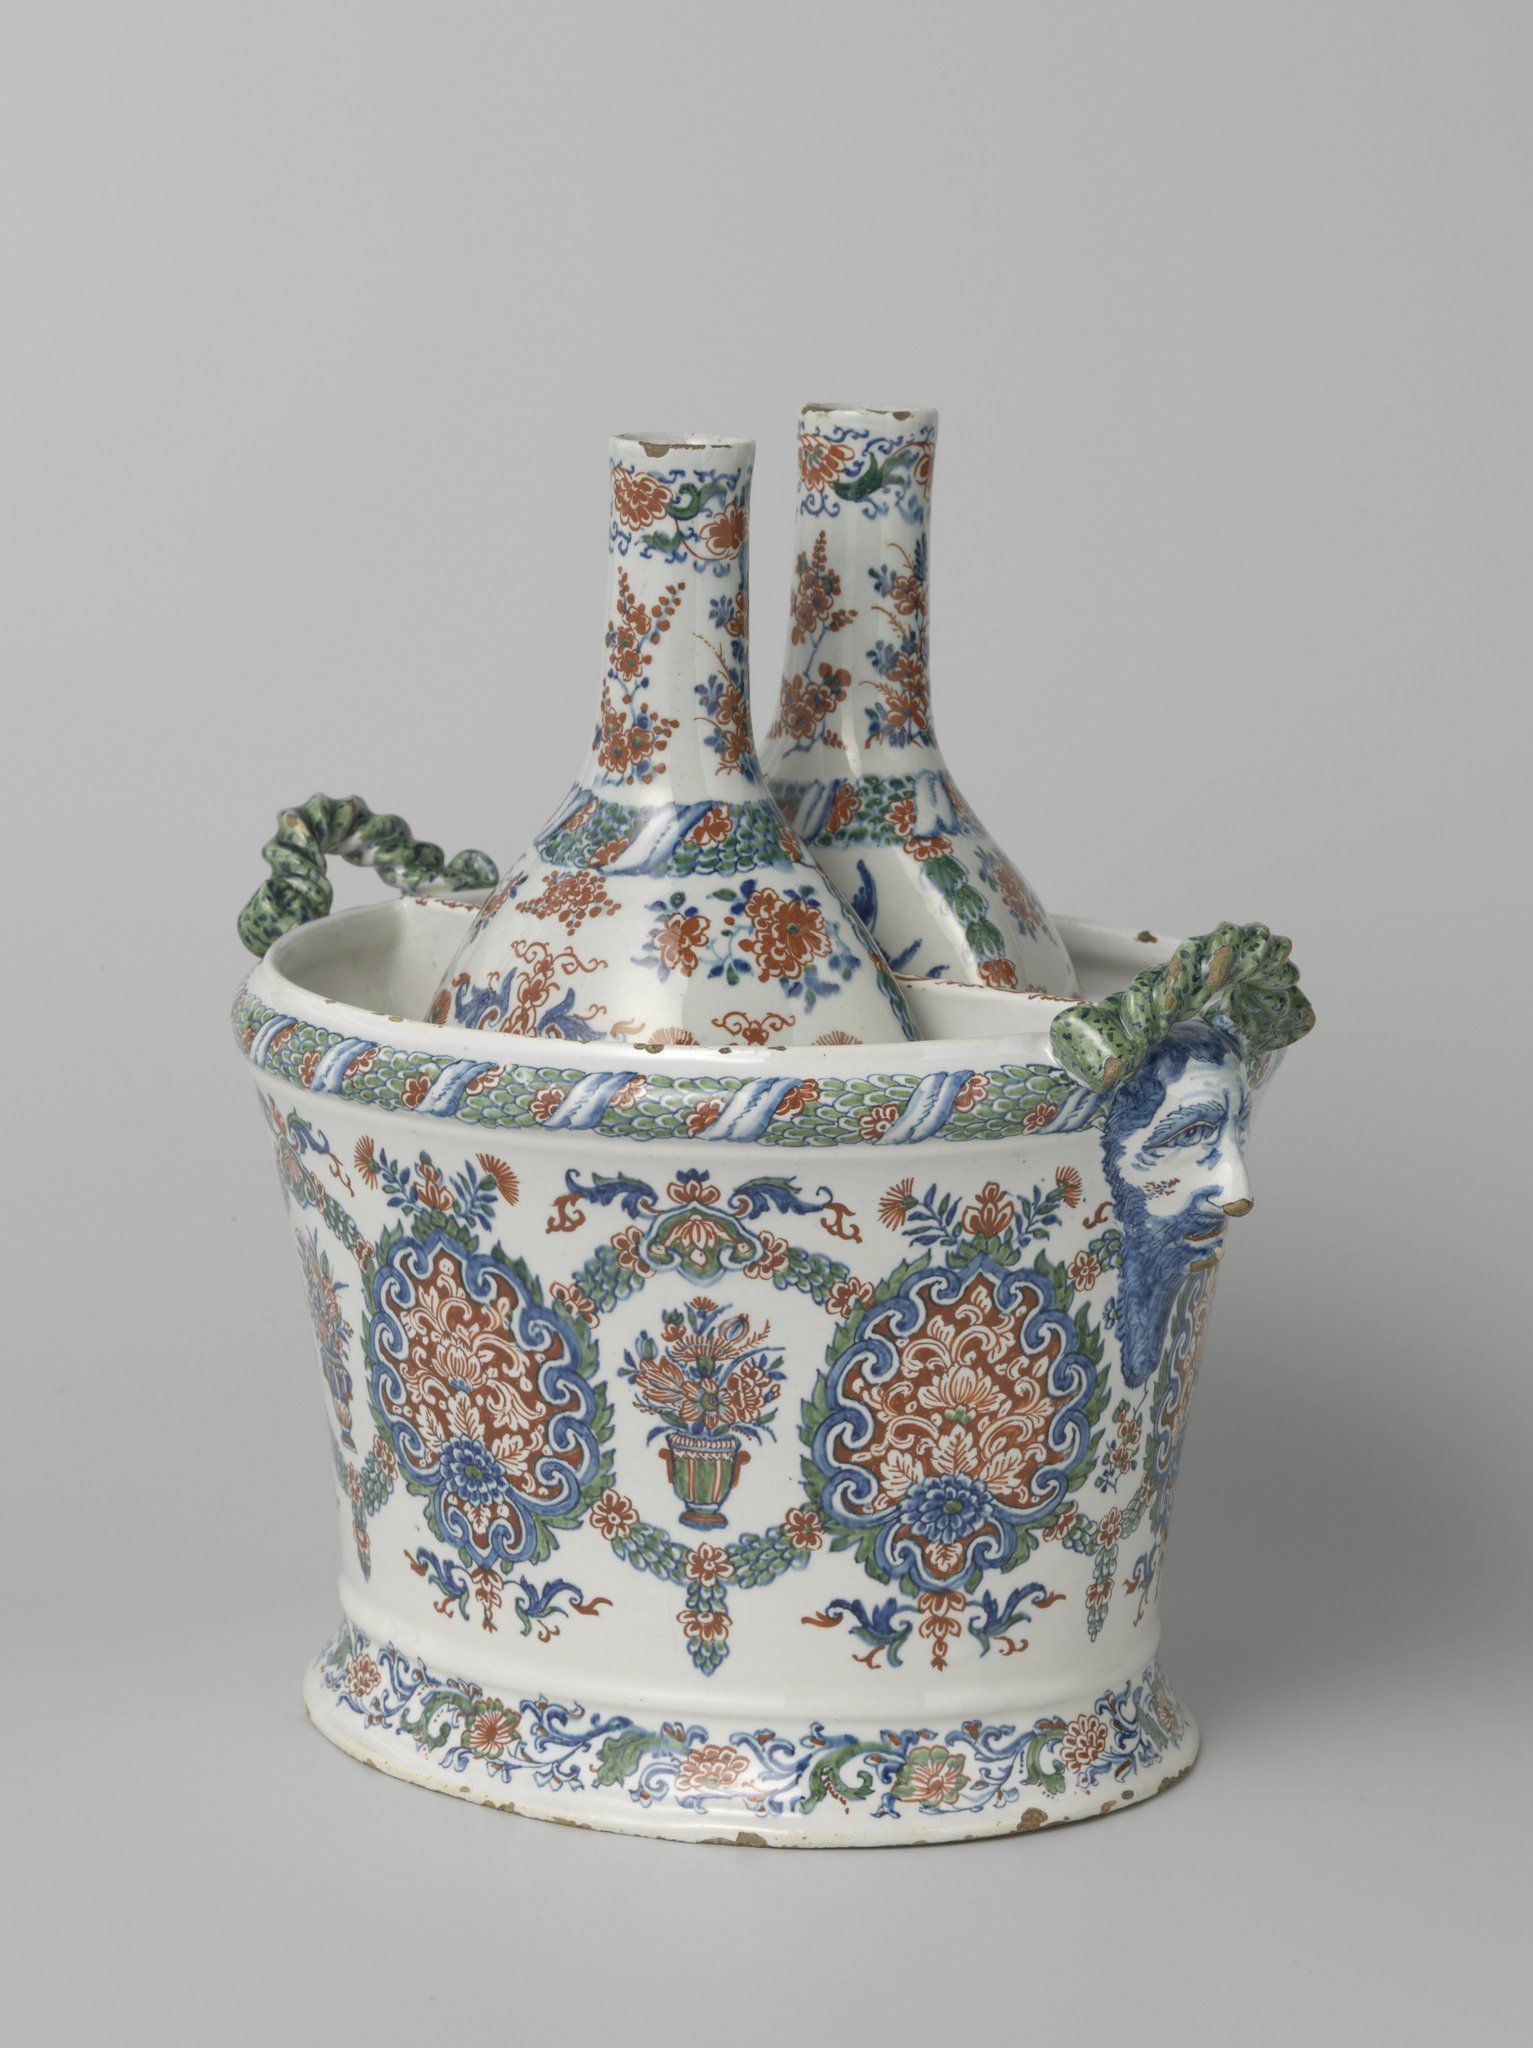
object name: wine cooler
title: Koelvat met twee flessen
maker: lambertus van eenhoorn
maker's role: plateelbakker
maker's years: 1651-1721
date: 1695-1715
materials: faience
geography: delft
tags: ornament derived from plant forms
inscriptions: mark: ‘LVE(ineen)/ 4/ A (?)’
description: Koelvat met twee flessen van faience. Veelkleurig beschilderd met bloemdecoraties.